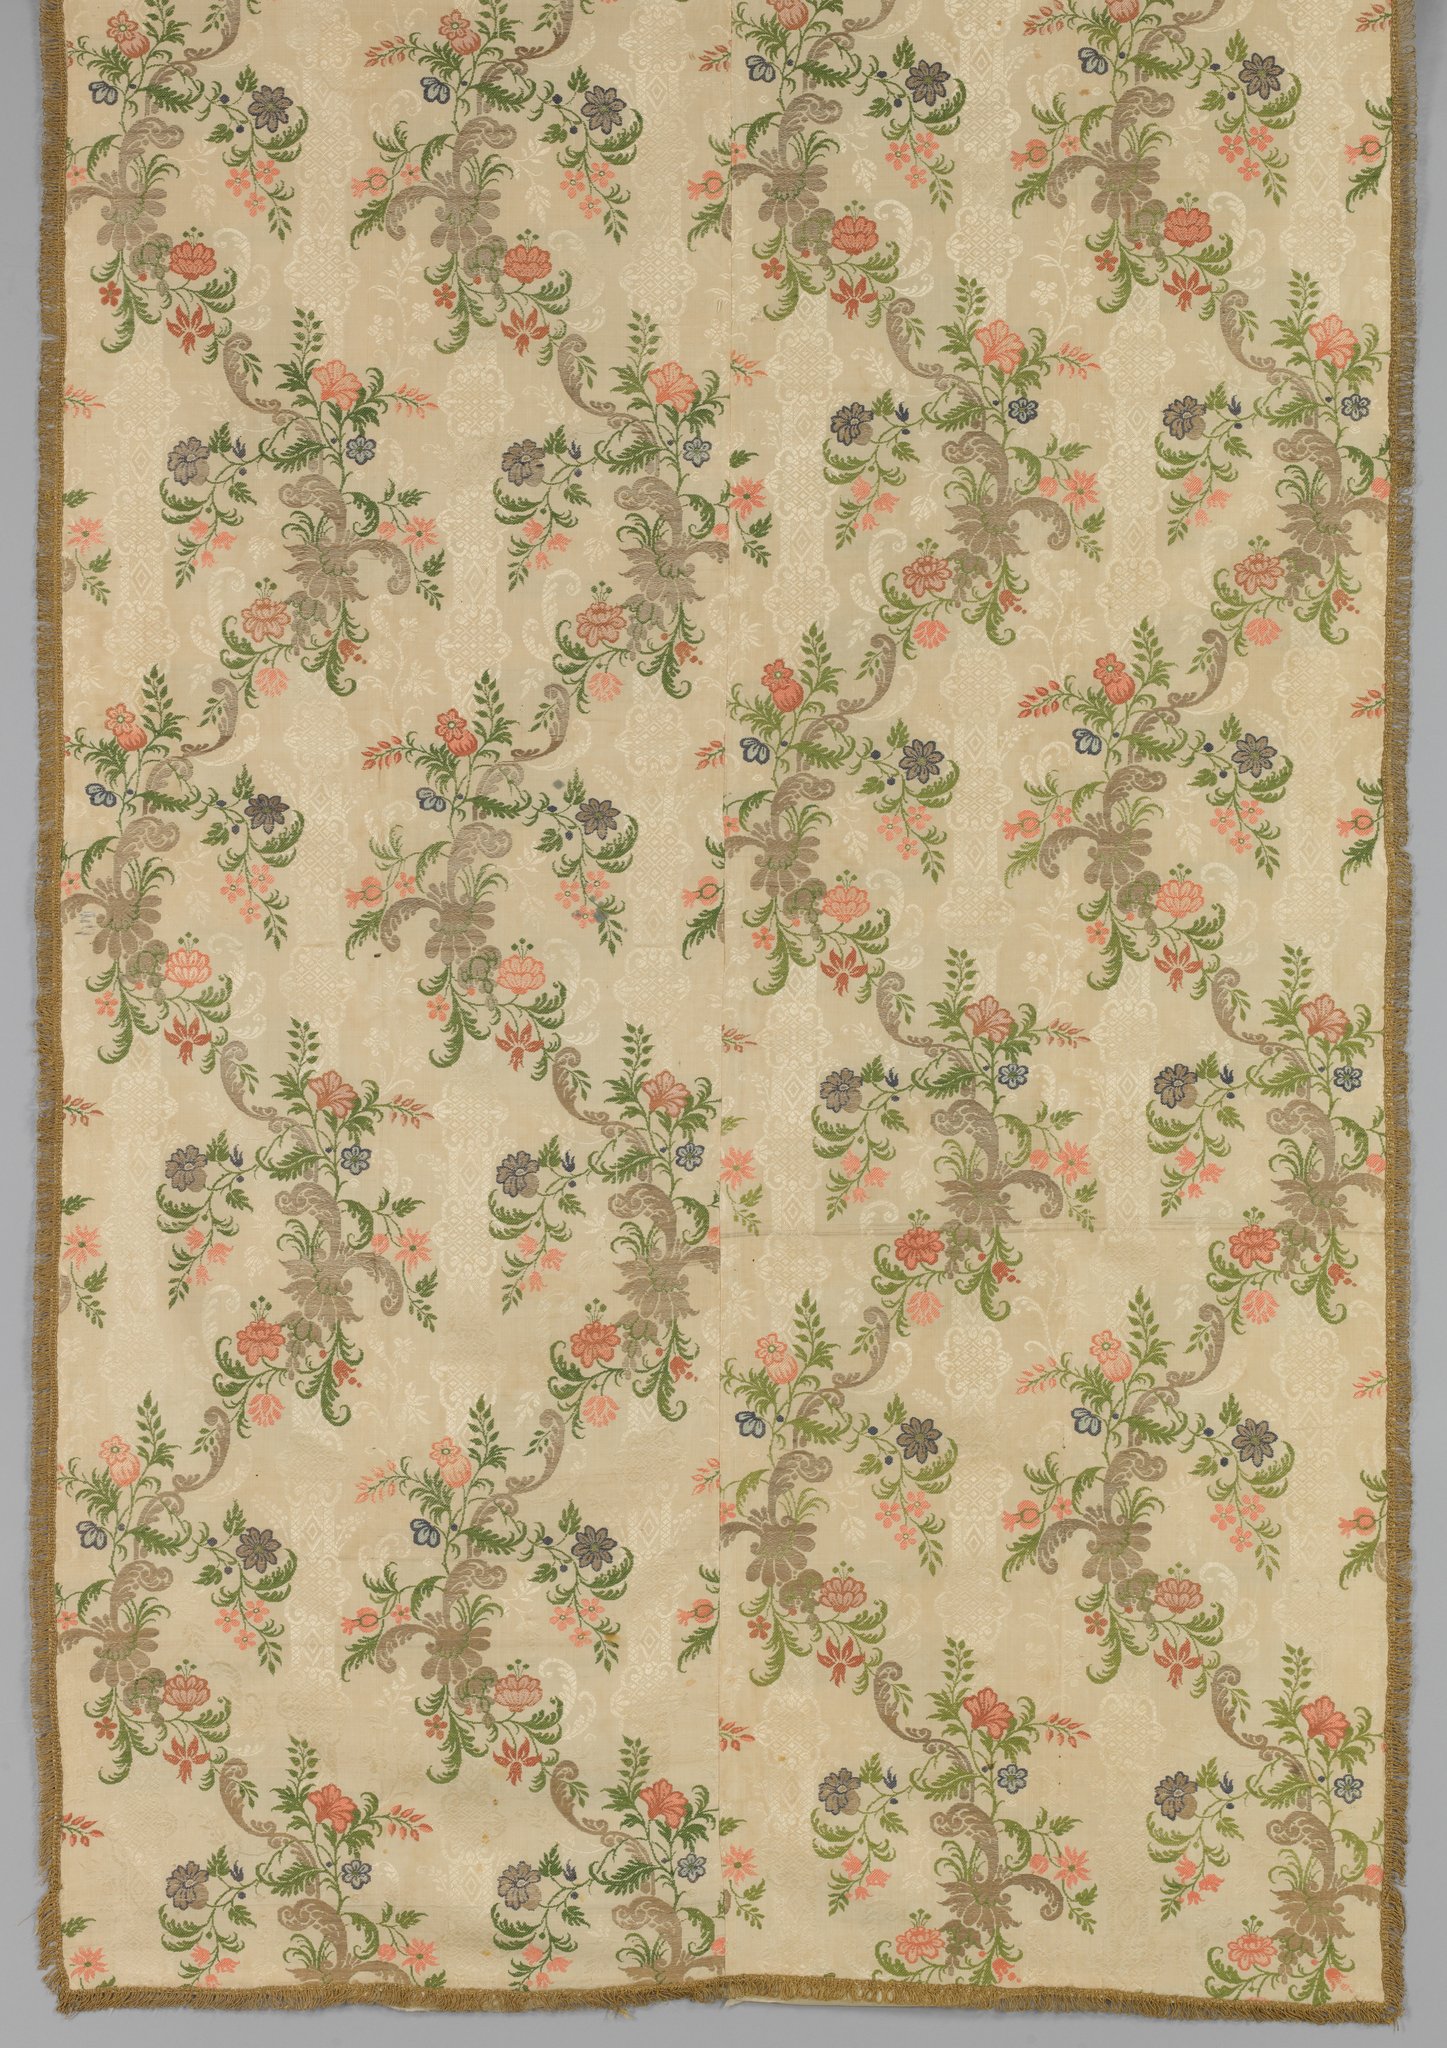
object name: panel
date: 1701-1800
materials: silk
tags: flowers